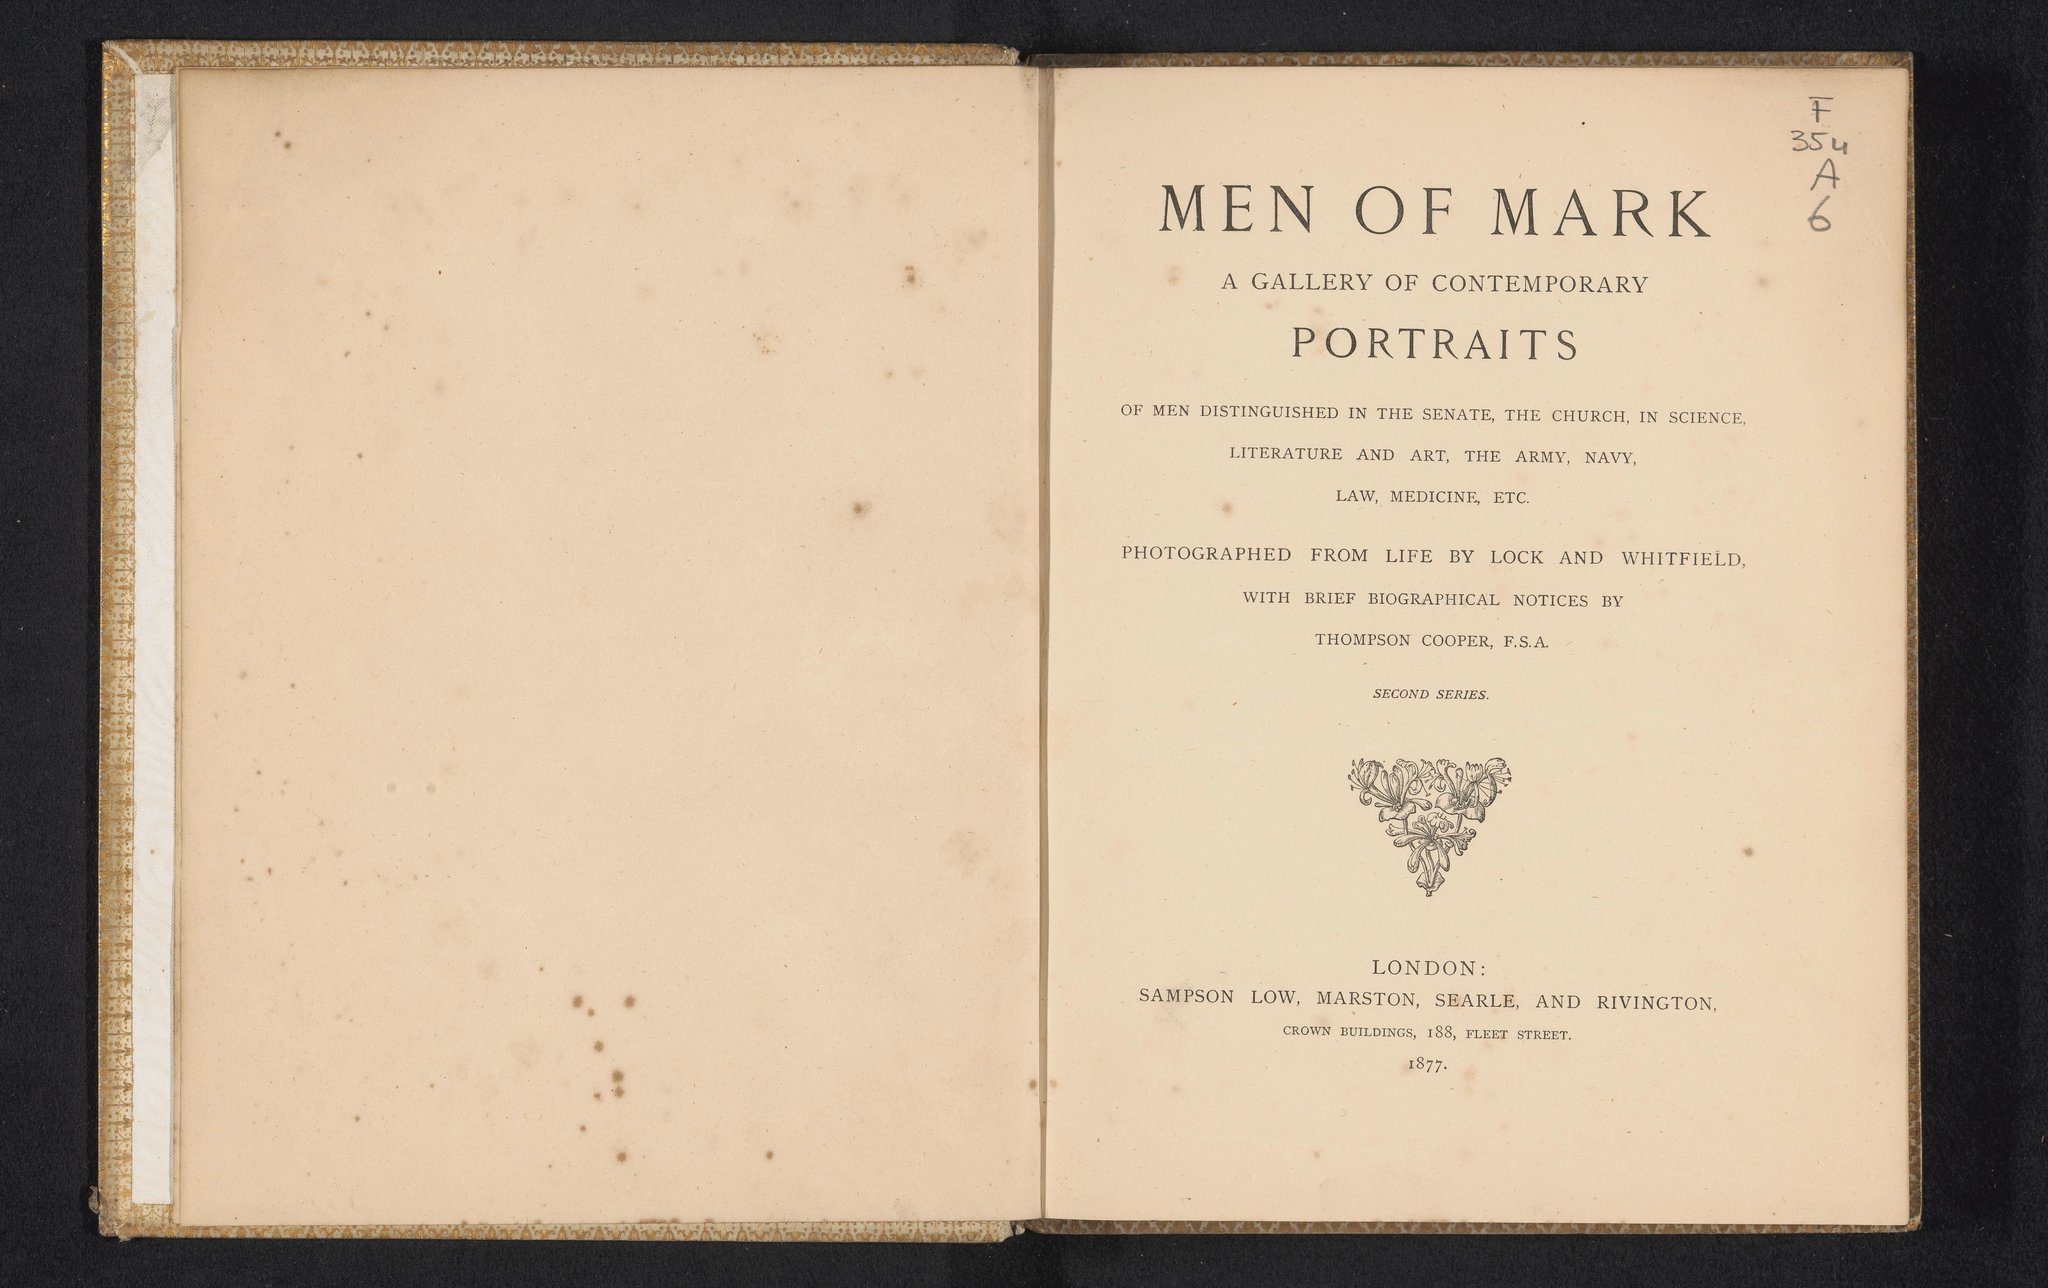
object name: book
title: Men of mark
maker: thompson cooper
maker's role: schrijver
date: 1877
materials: cardboard, linen, paper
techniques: printing, woodburytype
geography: london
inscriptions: inscription: ‘Booksellers stationers Greene's Library 16 Clare Street Dublin’